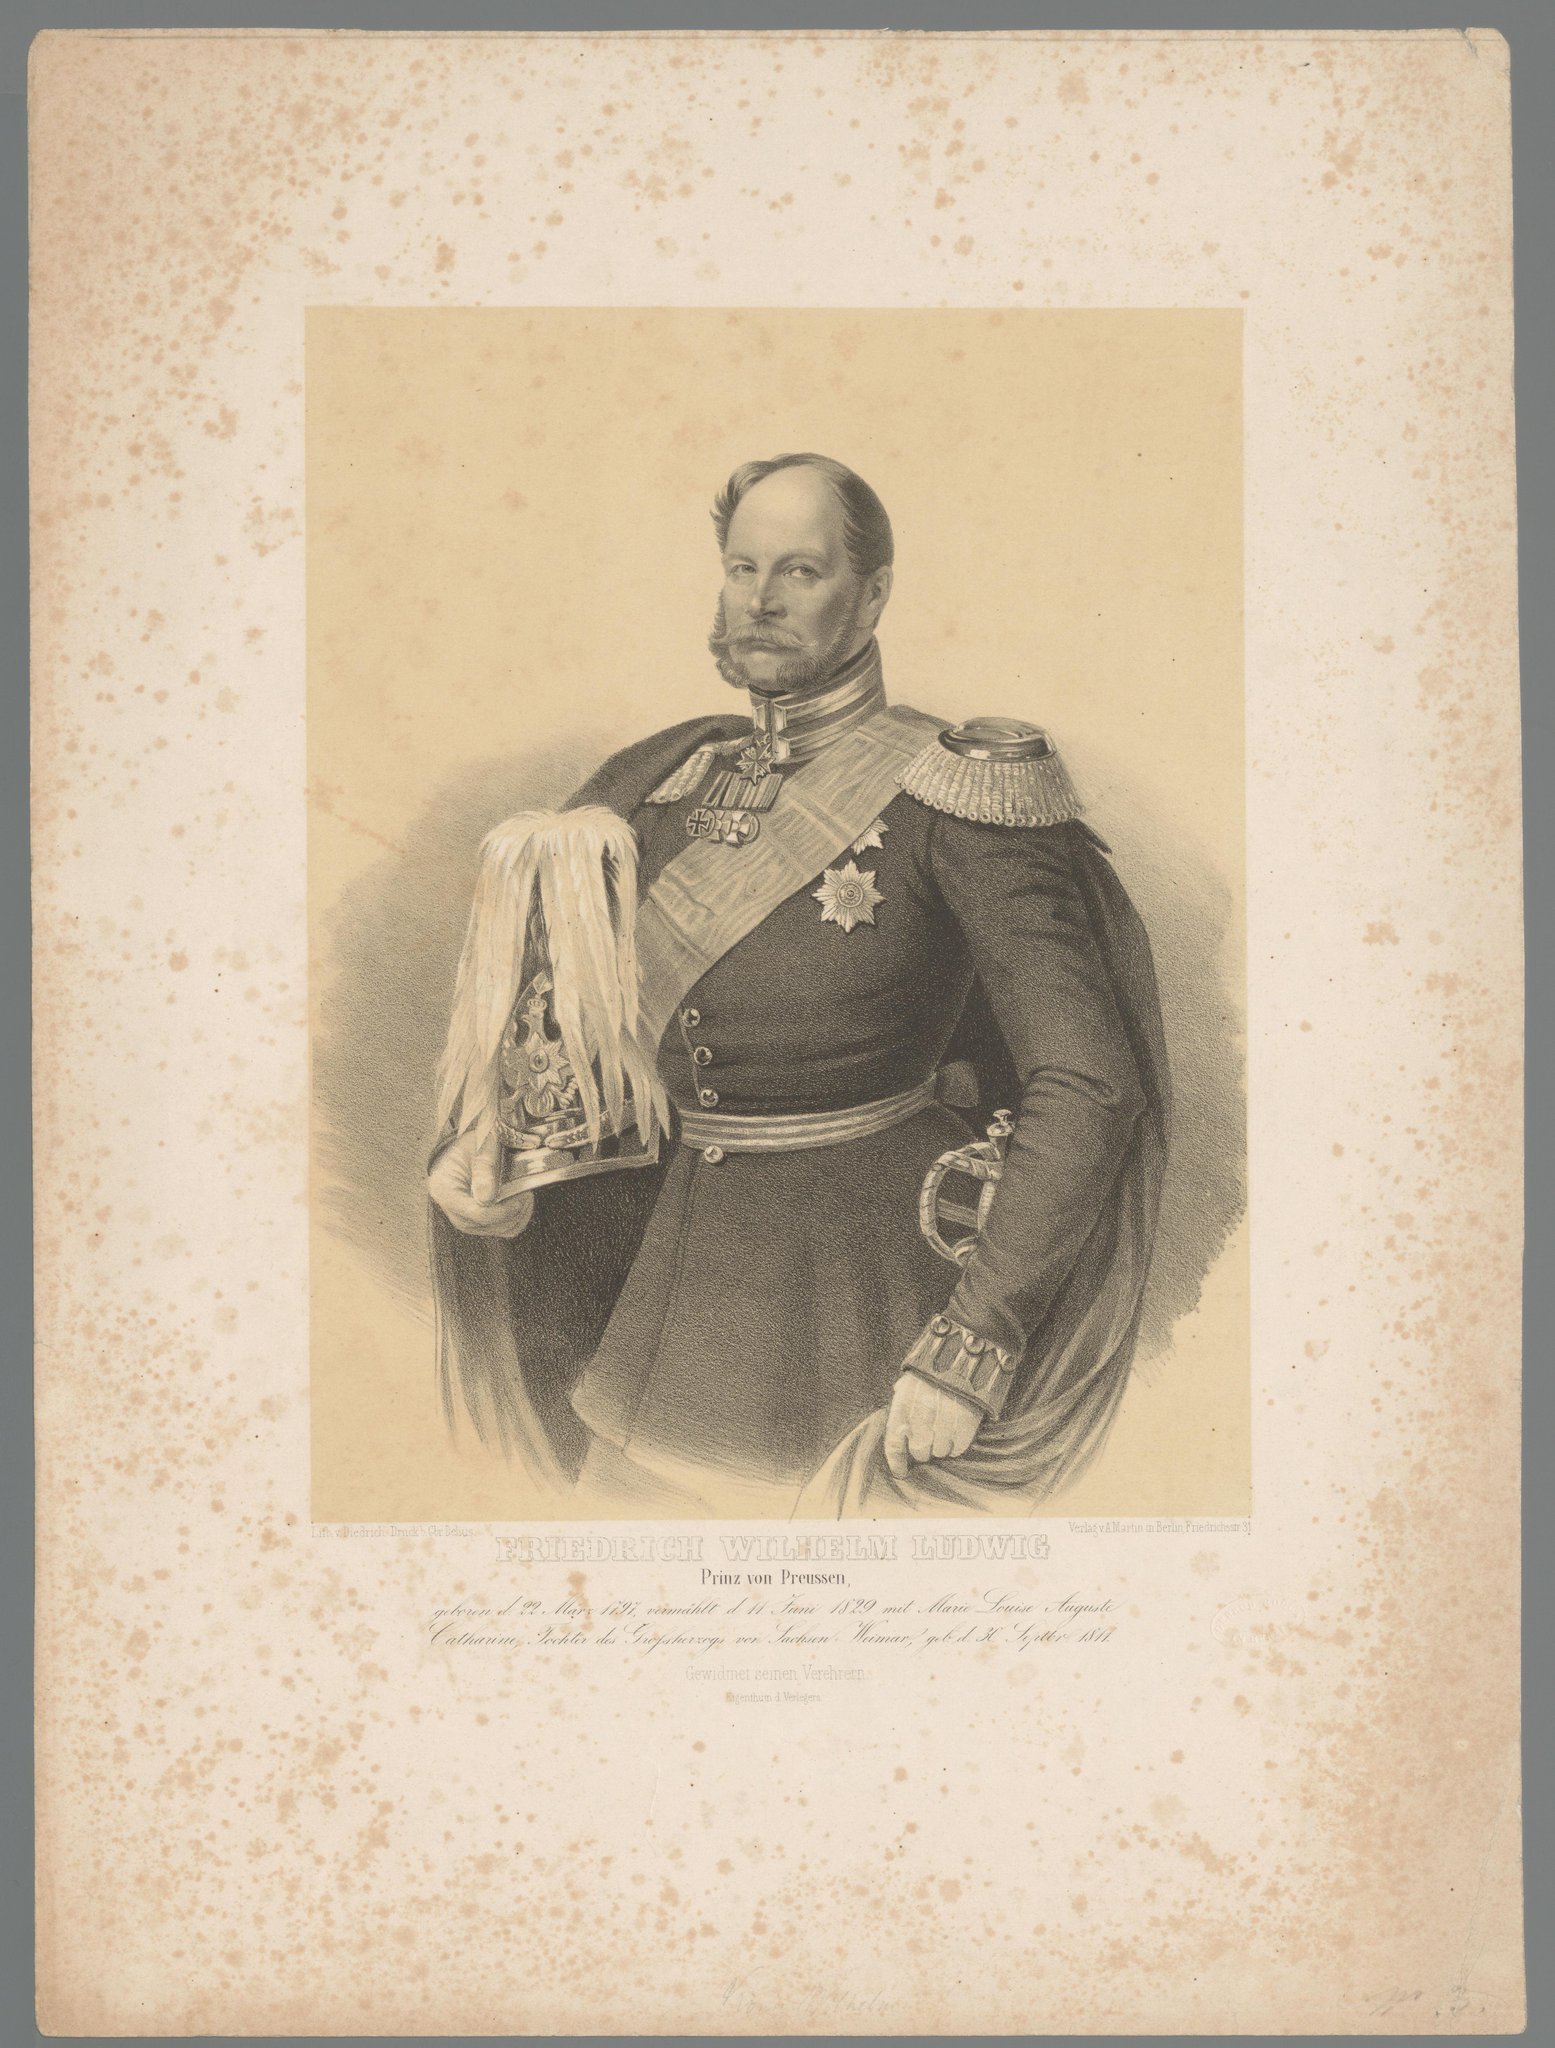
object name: print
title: Portret van keizer Wilhelm I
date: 1840-1850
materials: paper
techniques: tone lithography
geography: berlin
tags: berlin, wilhelm i (keizer van duitsland), historical persons, emperor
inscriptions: collector's mark: Lugt 2228